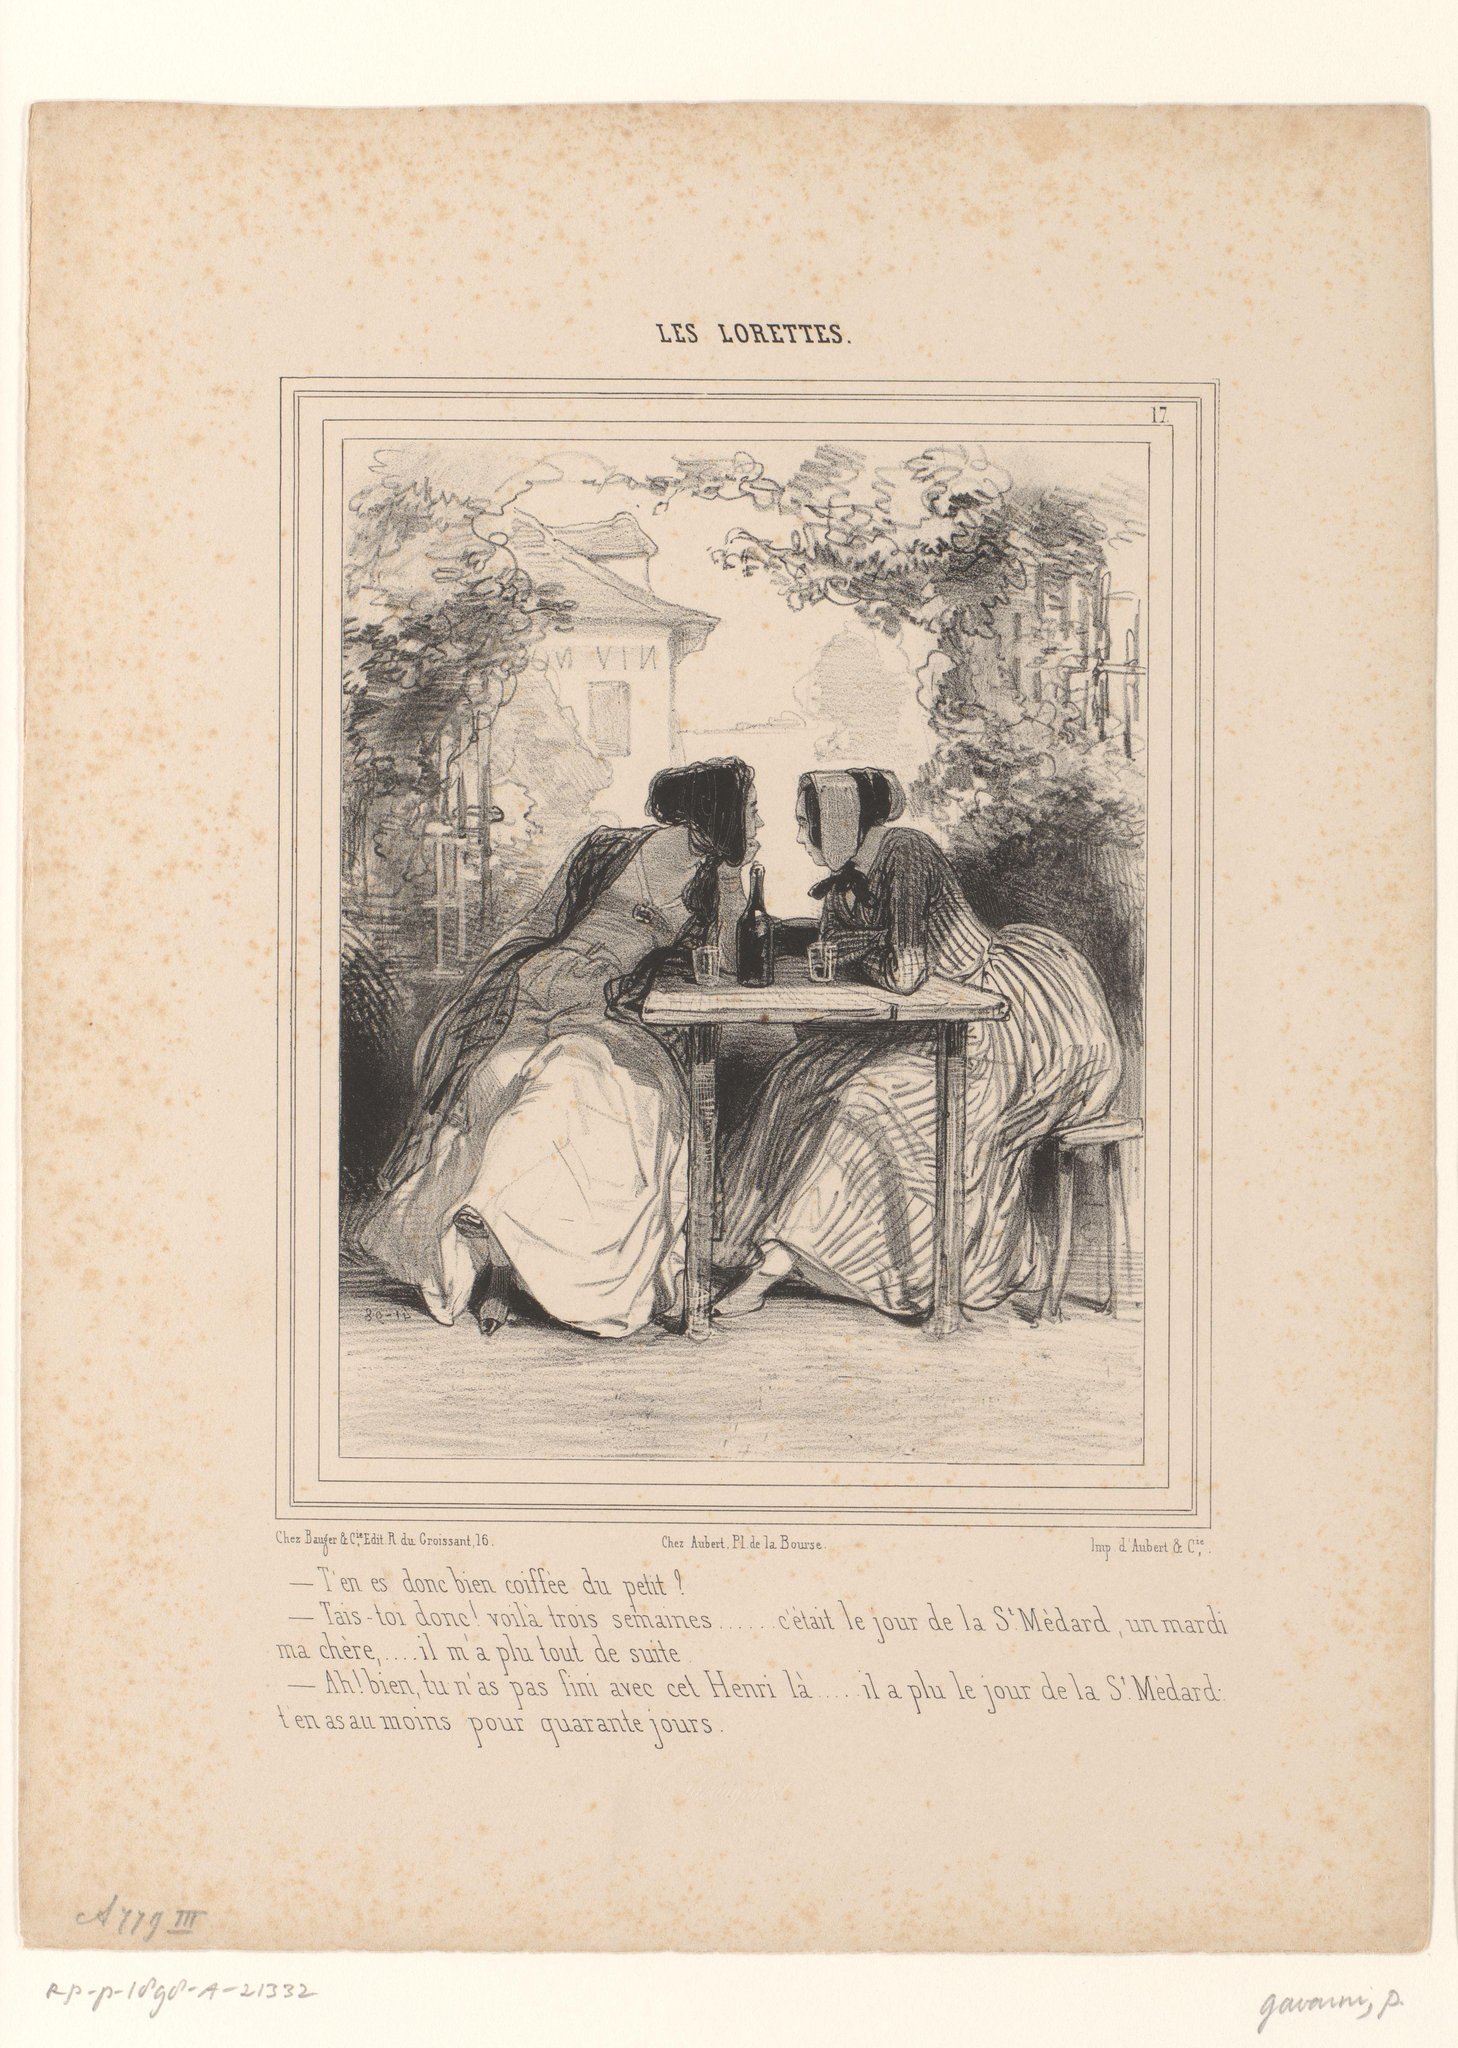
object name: cartoon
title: Les Lorettes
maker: paul gavarni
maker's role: draughtsman, print maker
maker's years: 1804-1866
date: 1842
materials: paper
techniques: lithograph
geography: paris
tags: pavement, terrace in front of inn or restaurant, bottle of wine, friends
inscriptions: collector's mark: Lugt 964, check stamp: Lugt 3855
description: Prent gebruikt voor: Le Charivari, 4 november 1841.